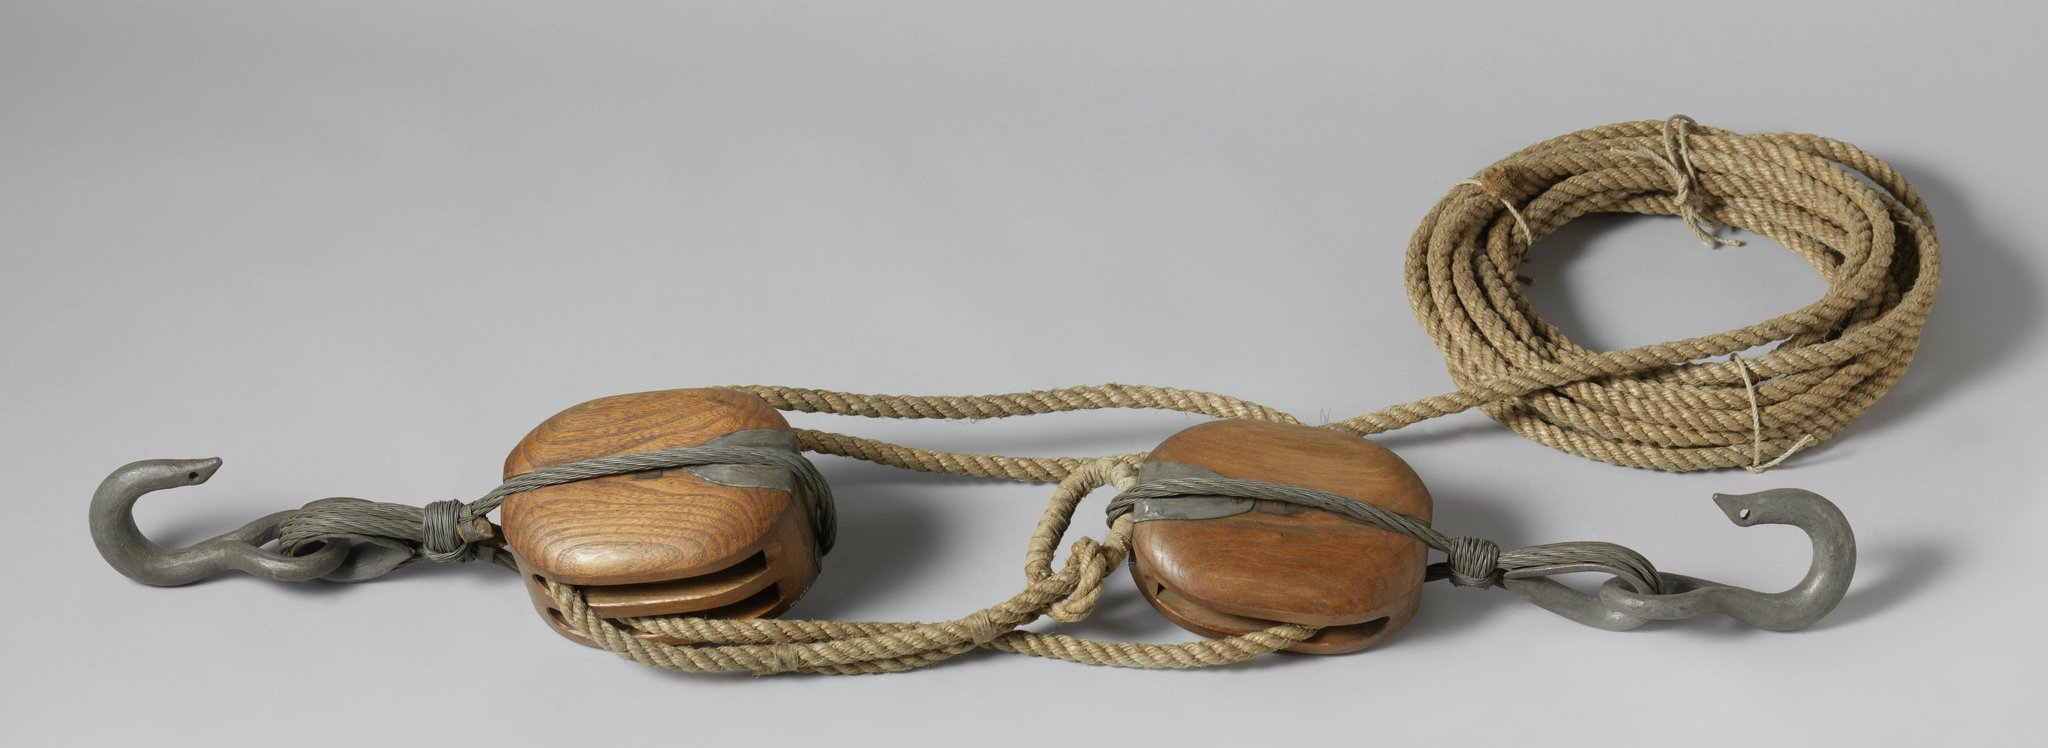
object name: tackle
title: Luff Tackle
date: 1861-1865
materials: iron, leather, linen, fiber, wood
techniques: galvanization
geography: hellevoetsluis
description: Een derdehandstakel volgens de voorschriften van 1865. De derdehandtalie bestaat uit een enkel- en een dubbelschijfsblok, het vaste part aan de strop van het enkele blok bevestigd; beide blokken hebben een ijzerdraad strop met ijzerdraad bindsel zonder splitsen, een ijzeren kous en een haak.